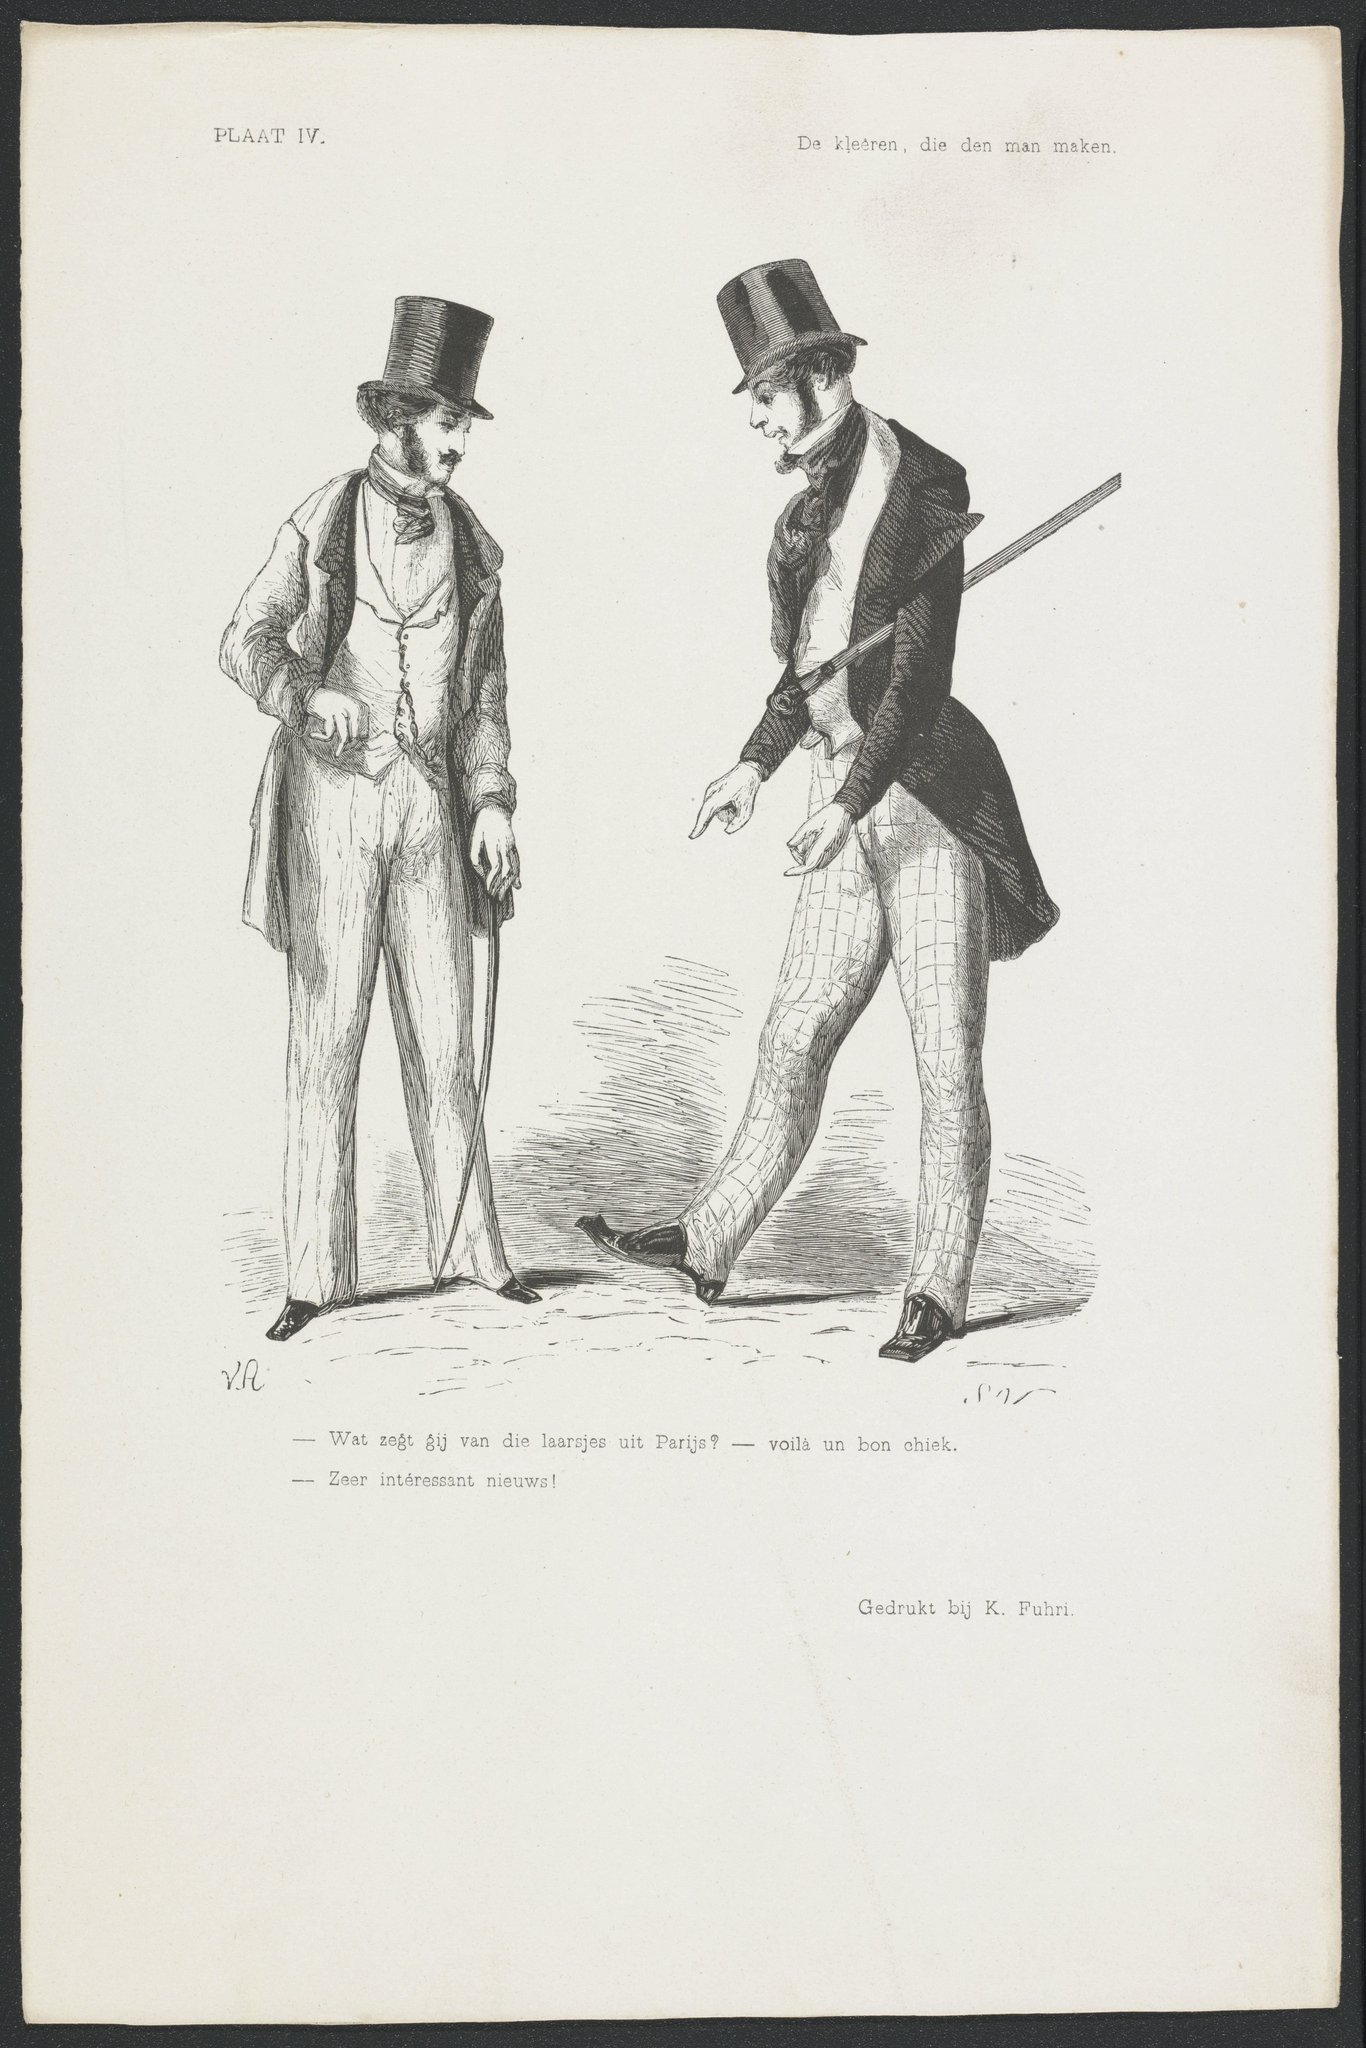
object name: print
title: Man toont zijn nieuwe schoenen uit Parijs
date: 1847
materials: paper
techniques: letterpress printing, engraving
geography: the hague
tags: shoes, sandals (+ men's clothes)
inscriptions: collector's mark: Lugt 2228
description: Twee mannen in modieuze kledij staan tegenover elkaar. In de ondermarge twee regels Nederlandse tekst in boekdruk.